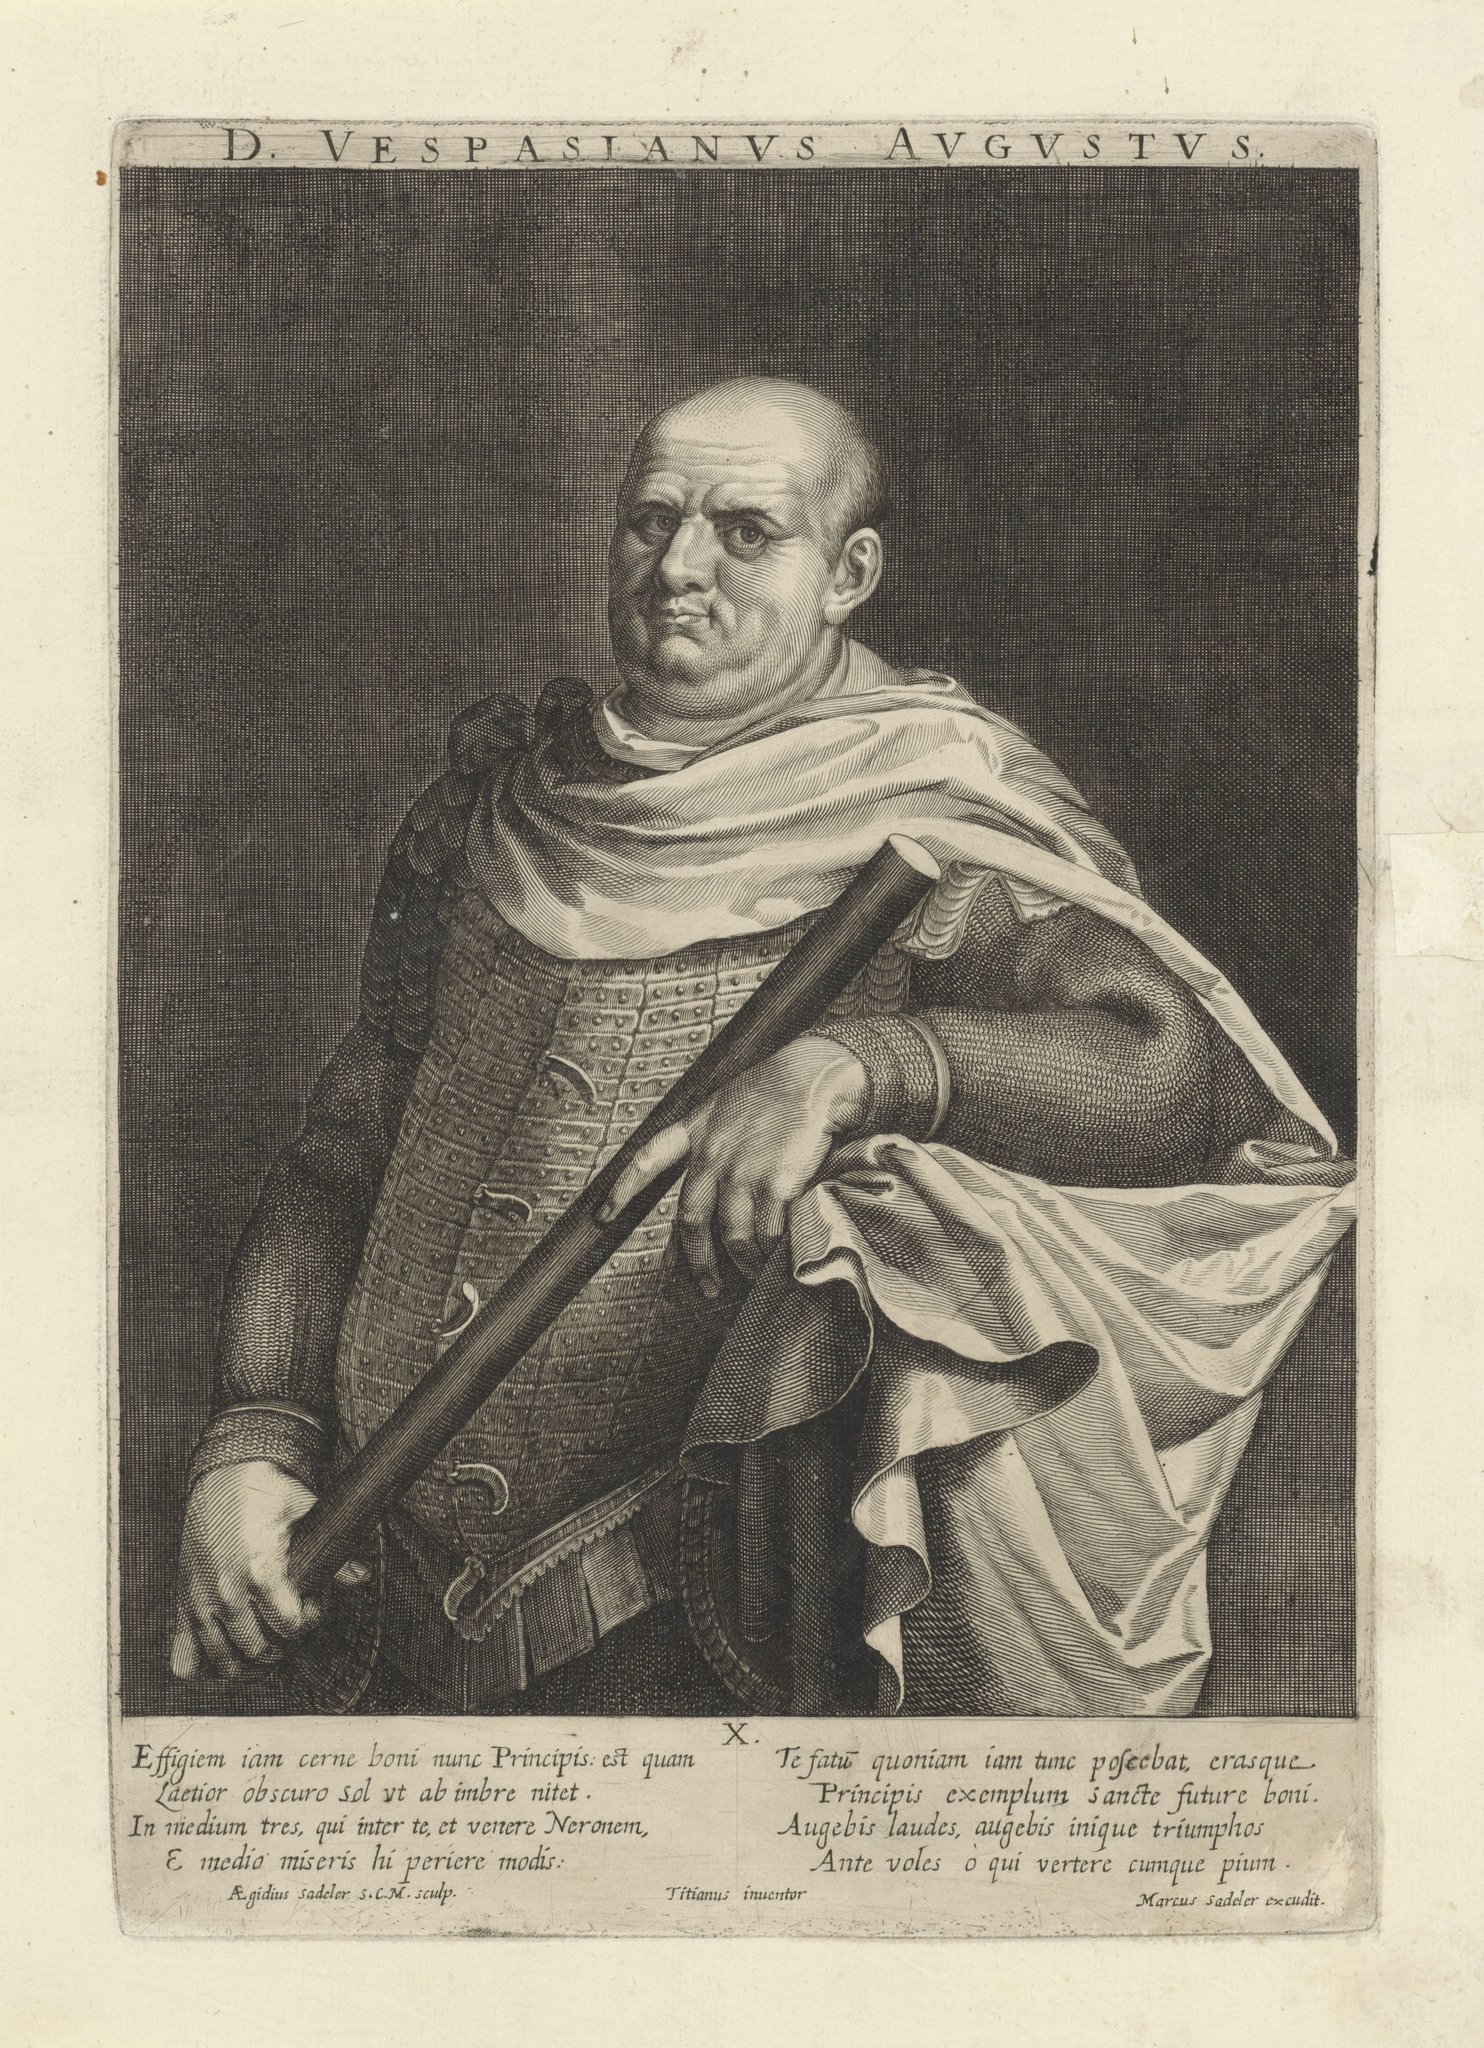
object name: print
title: Portret van keizer Vespasianus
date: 1597-1629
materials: paper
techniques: engraving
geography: prague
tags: cittareale, aquae cutiliae, vespasianus (keizer van het romeinse rijk)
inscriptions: collector's mark: Lugt 240